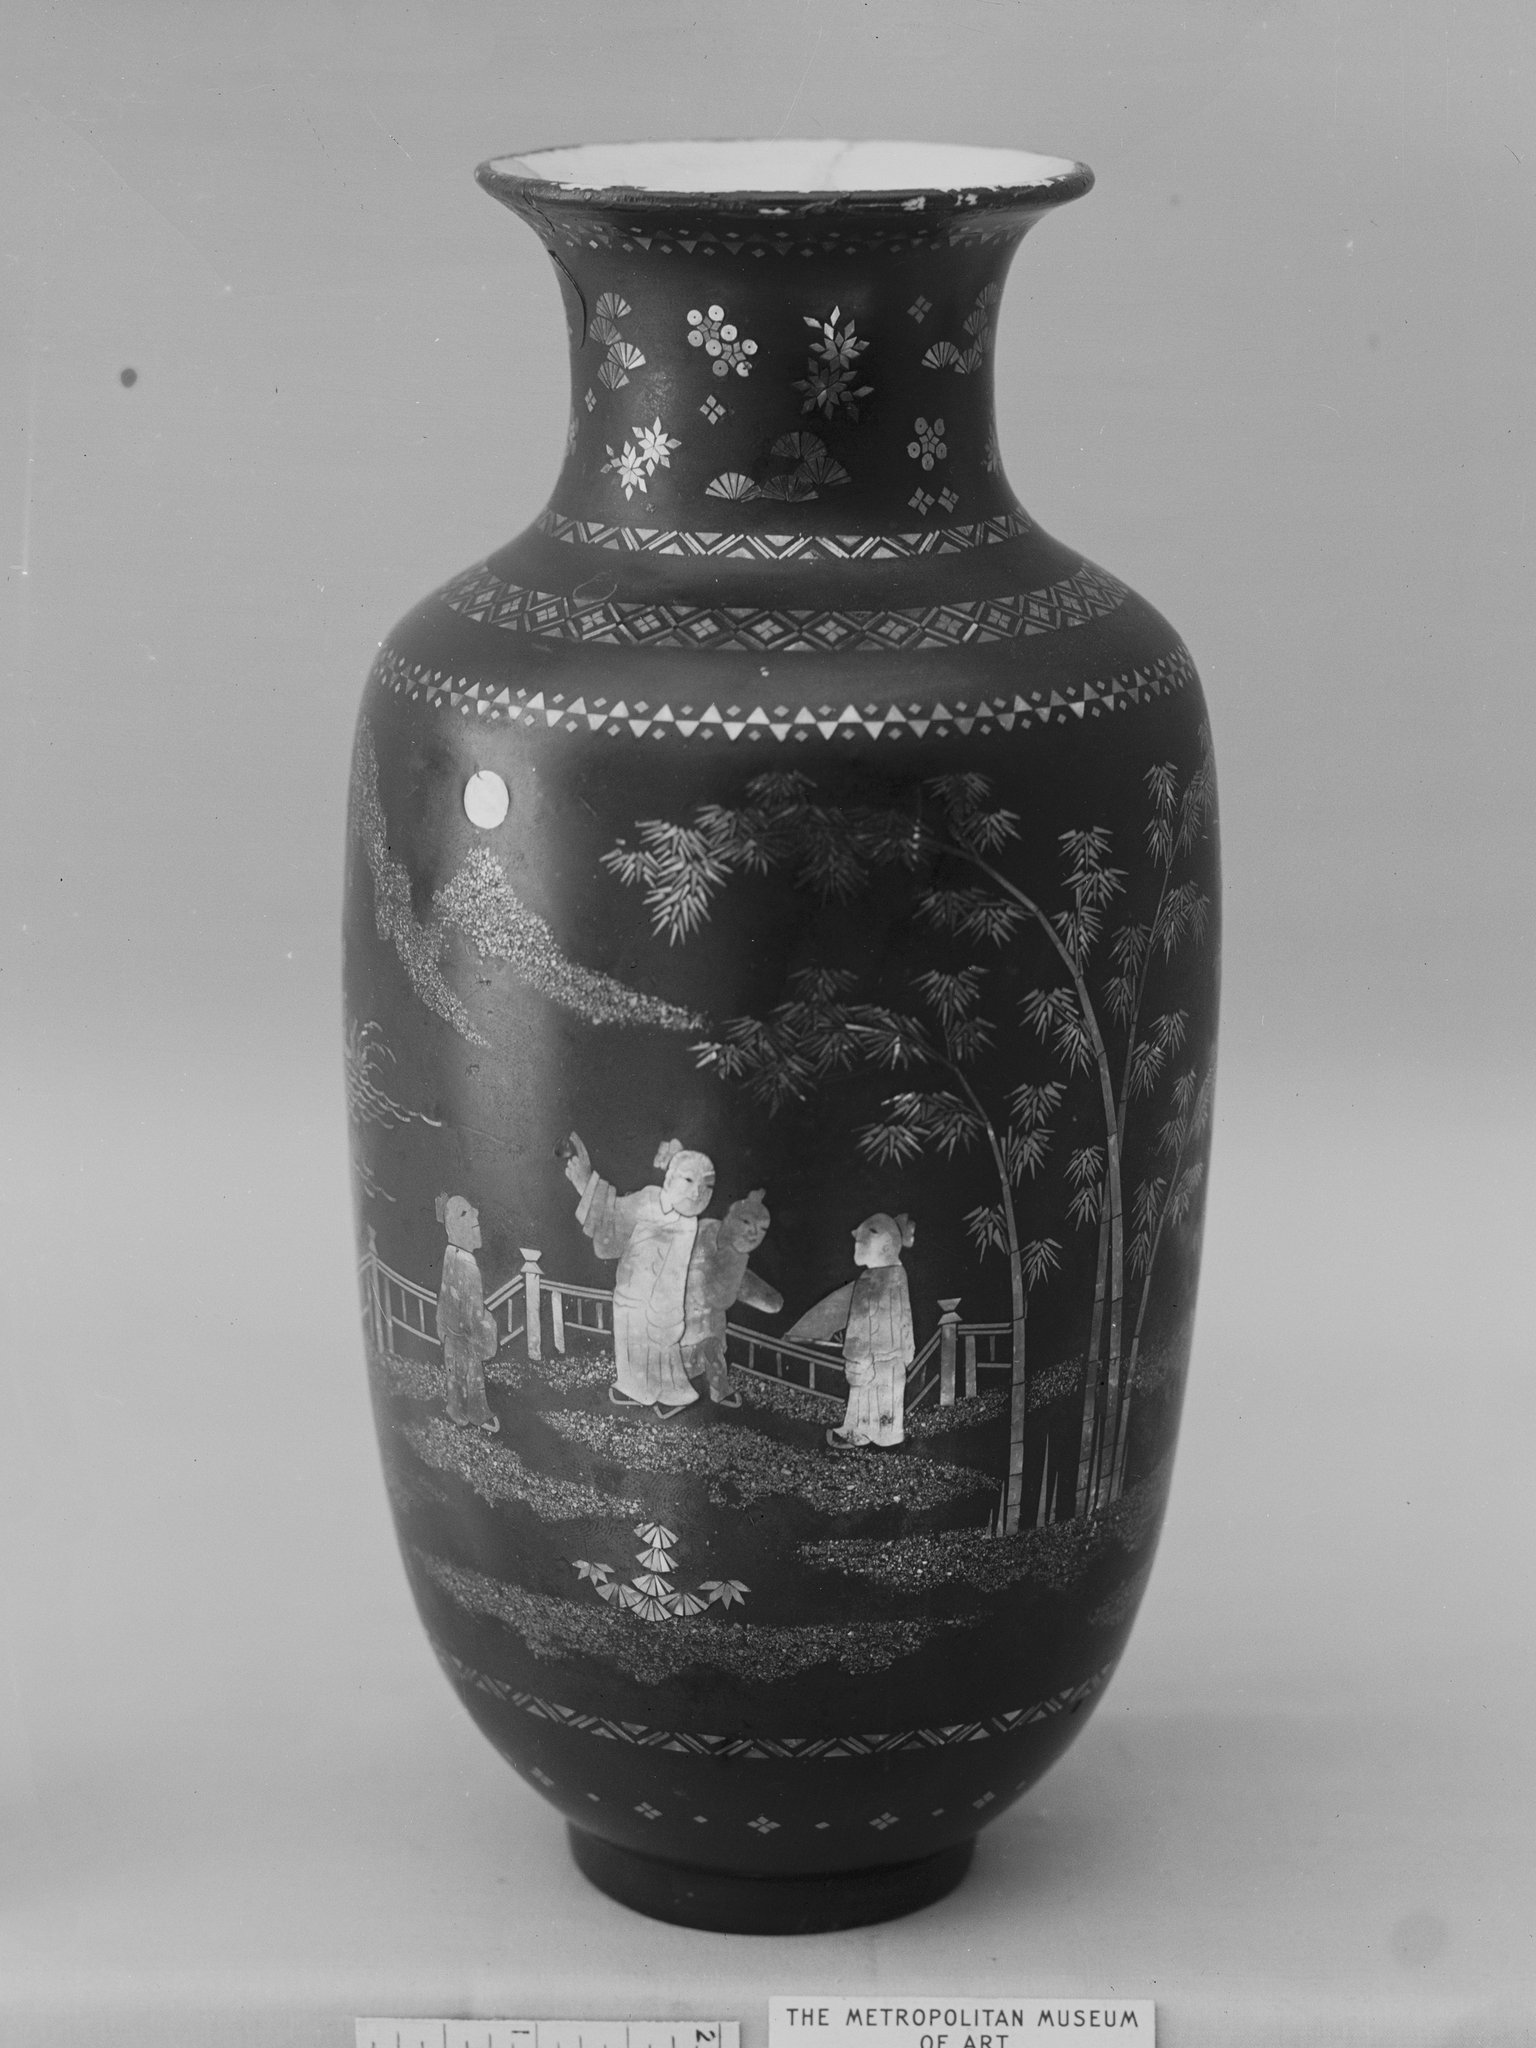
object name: vase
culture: chinese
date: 1736-1795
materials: lacquer, mother of pearl, porcelain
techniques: inlay, underglaze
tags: human figures,moon,bamboo